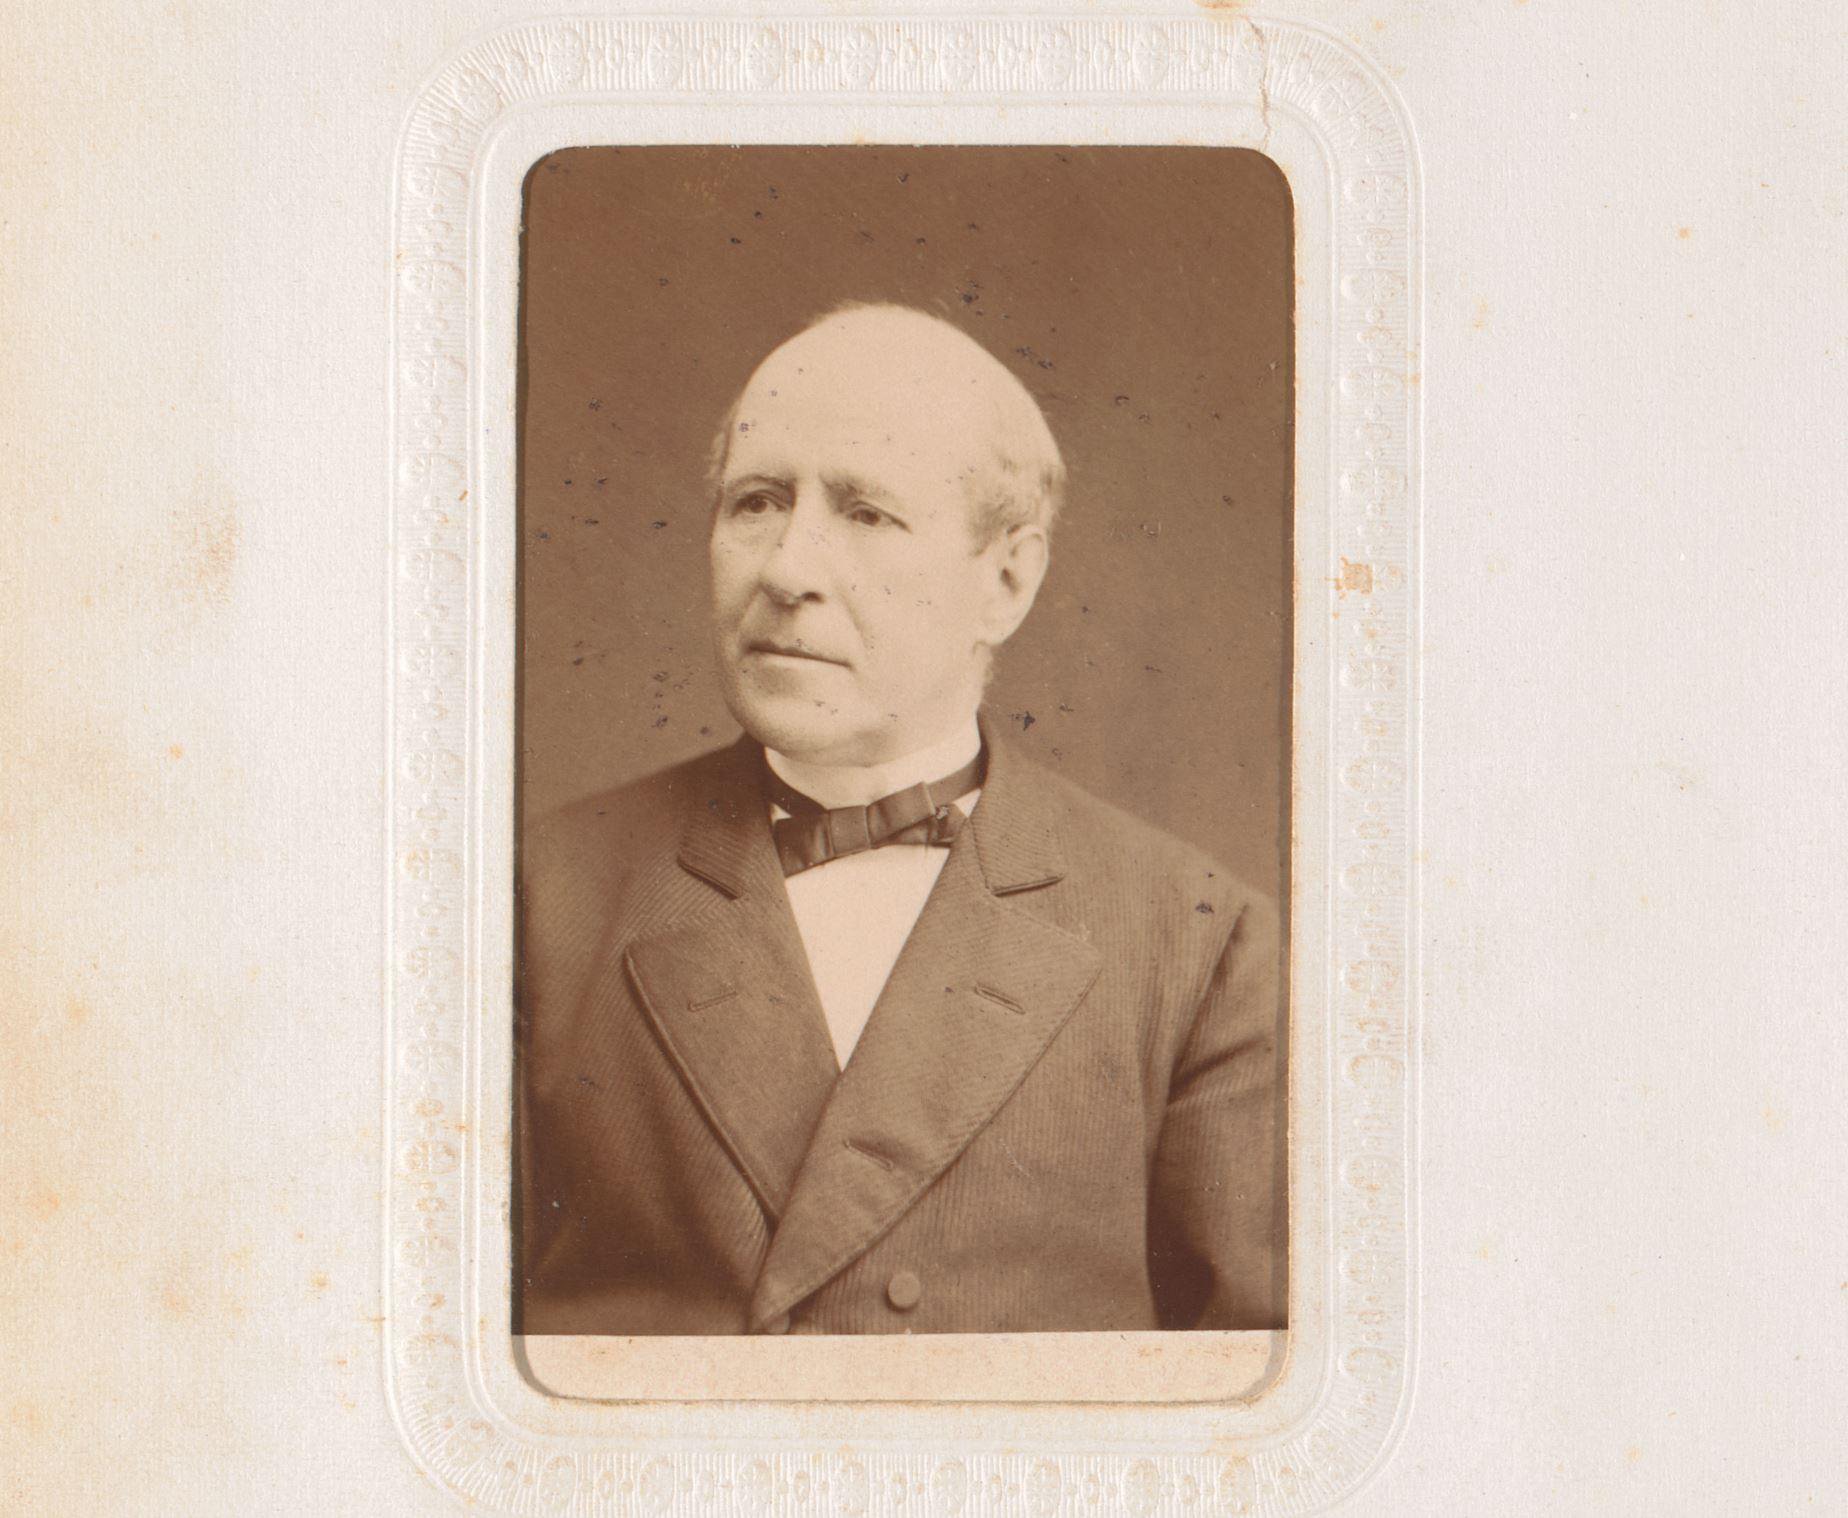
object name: album leaf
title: Portret van een man met vlinderstrik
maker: Anonymous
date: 1860-1900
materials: cardboard, photographic support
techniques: albumen print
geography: netherlands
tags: historical persons